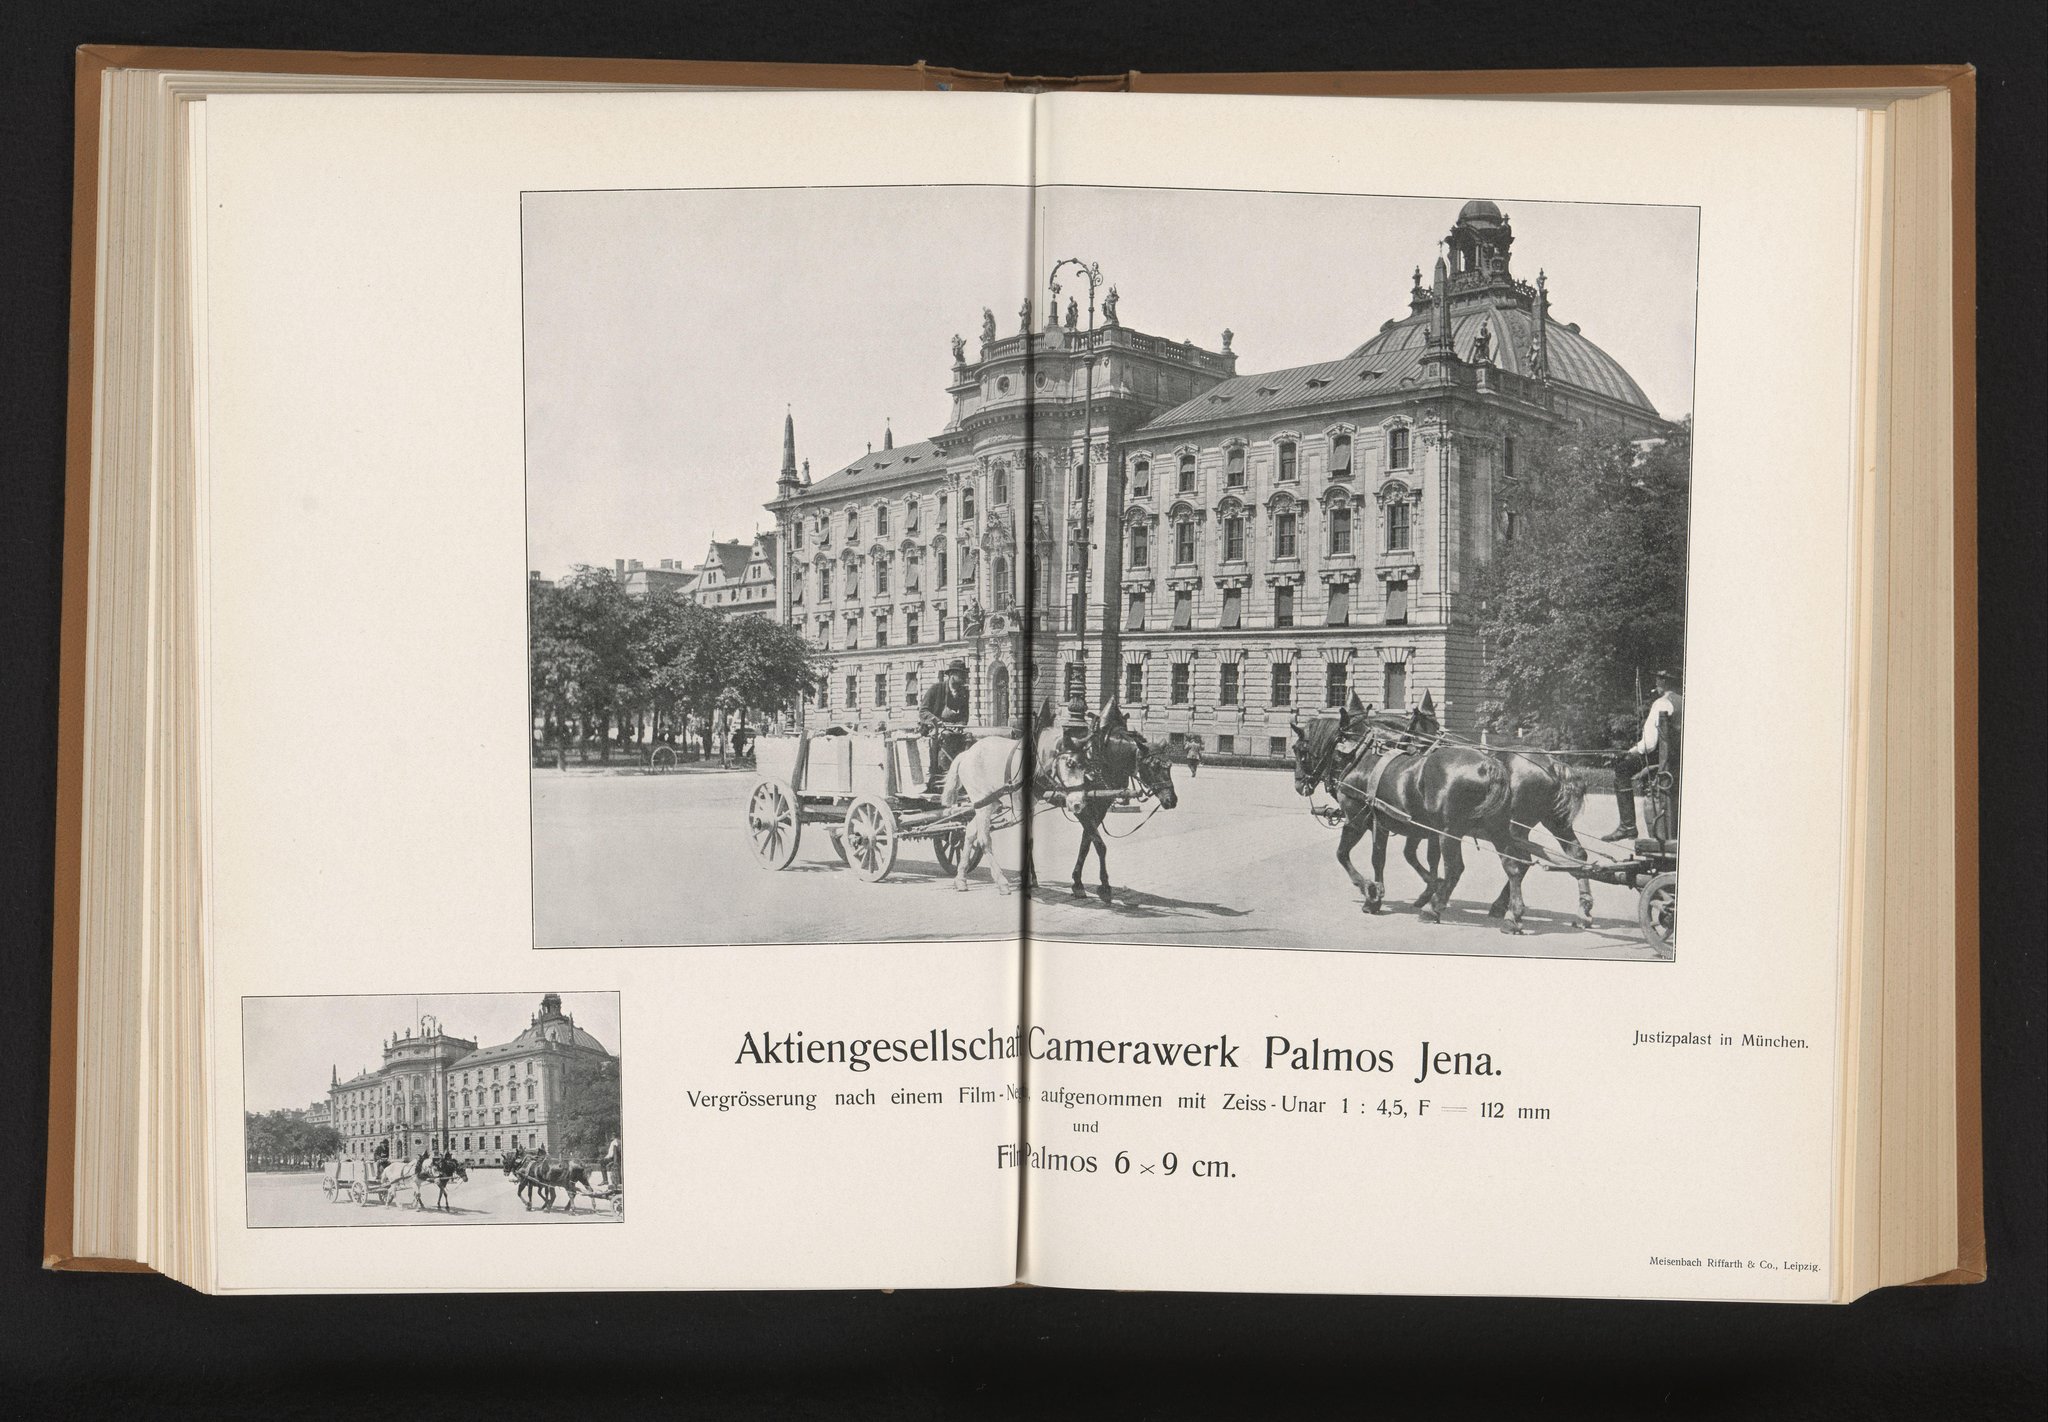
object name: photomechanical print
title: Twee gezichten op het Paleis van Justitie in München, Duitsland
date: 1895-1900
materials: paper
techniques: autotype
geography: leipzig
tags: square, place, circus, etc. (+ city(-scape) with figures, staffage)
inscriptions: inscription: ‘Aktiengesellschaft Camerawerk Palmos Jena./ Vergrösserung nach einem Film-Negativ, aufgenommen mit Zeiss-Unar 1:4,5, F=112 mm/ und/ Film Palmos 6 x 9 cm.’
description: Prenten op tweede en derde ongenummerde pagina na pagina 204. Deze prenten maken deel uit van een reclameboodschap voor Aktiengesellschaft Palmos Jena, een fabrikant van fotocamera's.